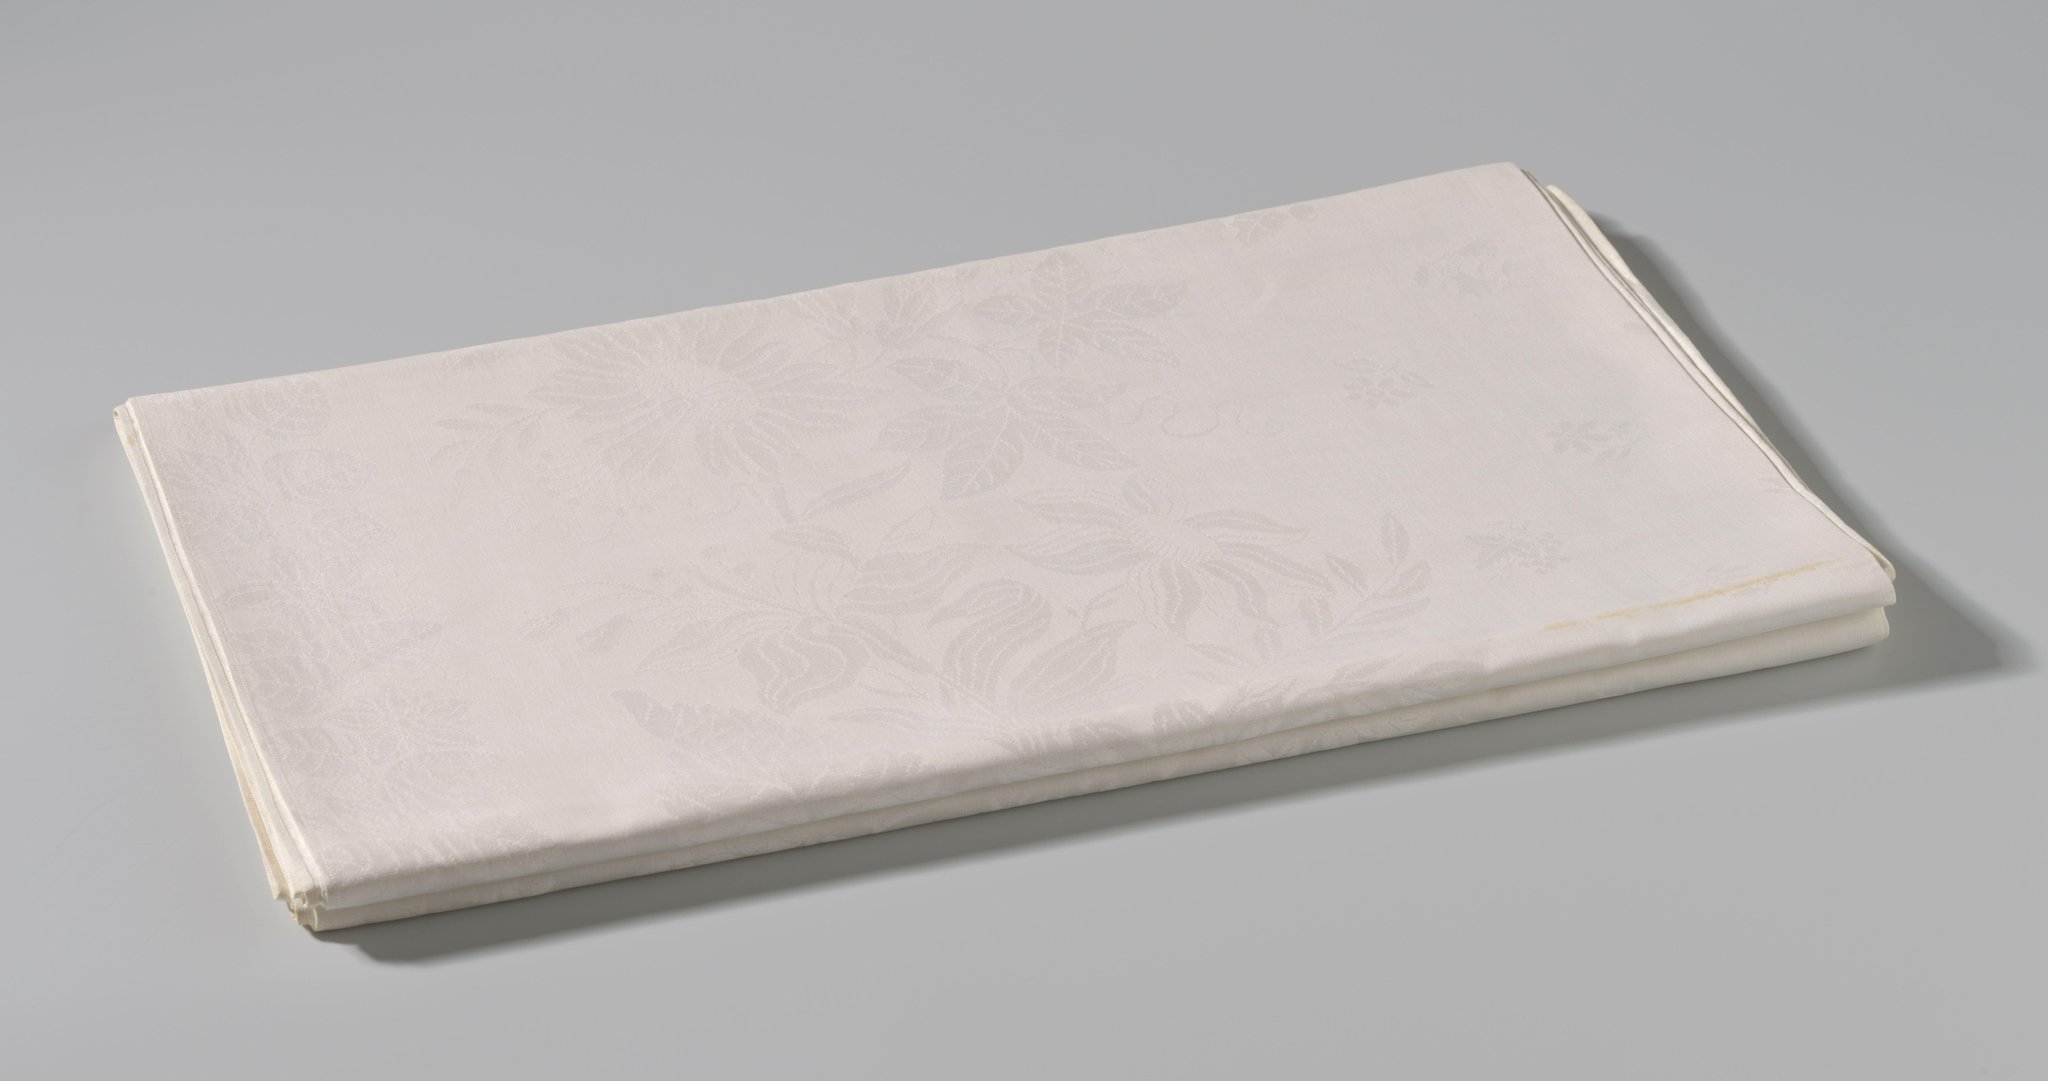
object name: tablecloth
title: Tafellaken van linnendamast met een bloempatroon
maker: Anonymous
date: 1800-1850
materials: linen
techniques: damask, weave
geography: netherlands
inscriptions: mark: ‘.L.’, mark: ‘BG 2’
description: Tafellaken van linnendamast met een bloempatroon. Het tafellaken hoort bij acht servetten (BK-1976-121-A t/m BK-1976-121-H).